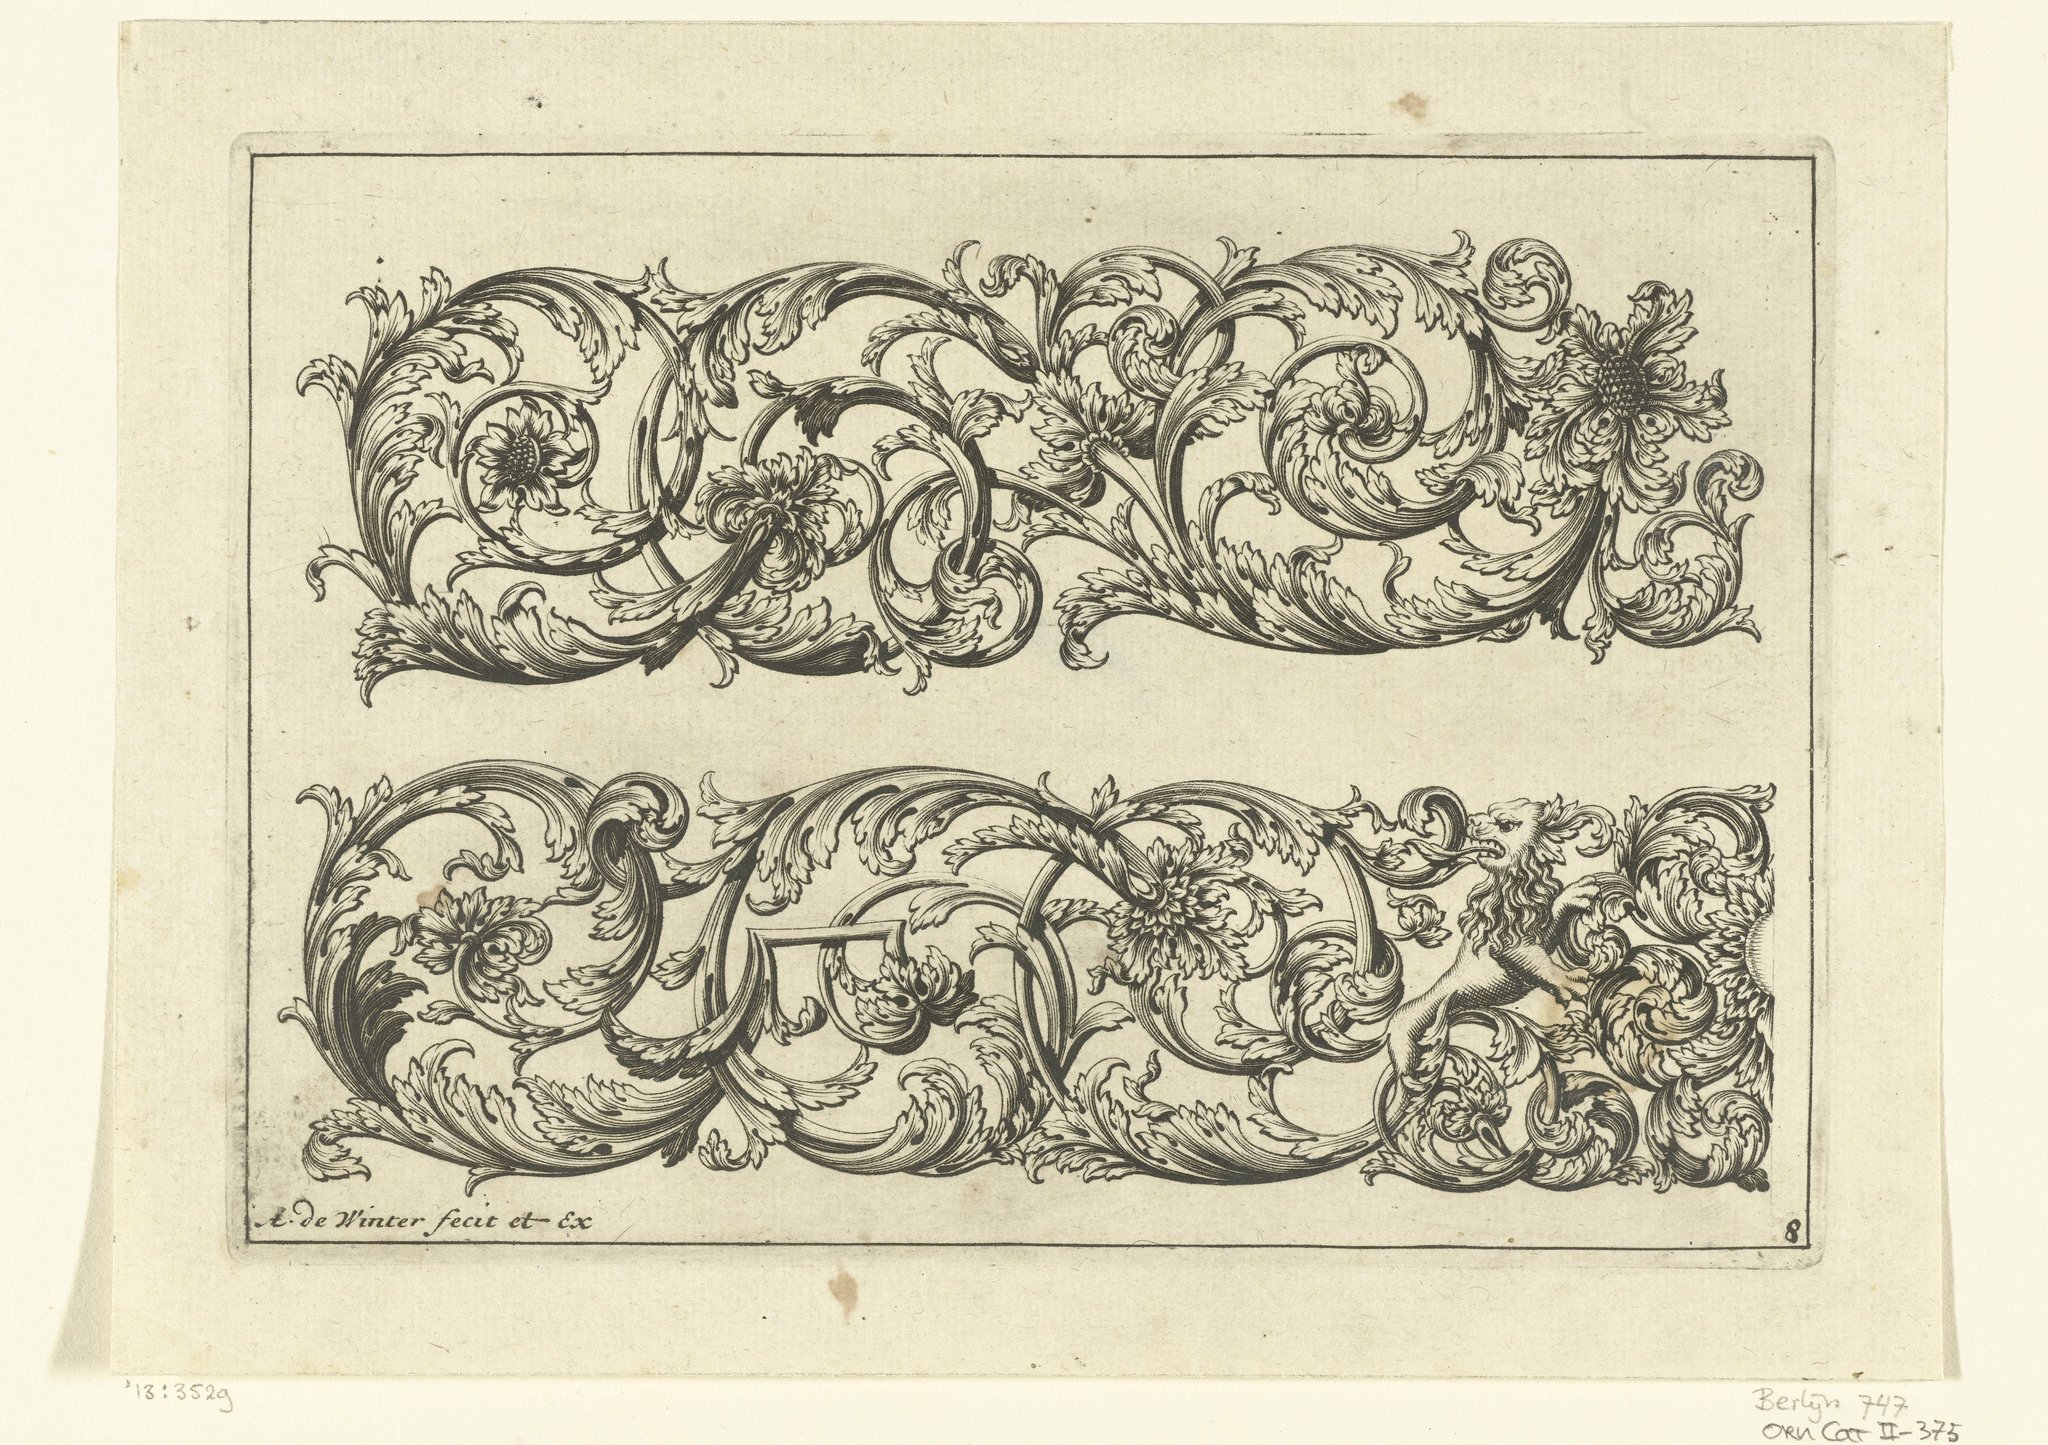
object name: ornament print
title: Nouveau Livre d'Ornemens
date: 1690-1700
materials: paper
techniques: engraving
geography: amsterdam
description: Blad uit serie met kopieën naar Stefano della Bella, Gilles Légaré, Thomas Lejuge en anderen.